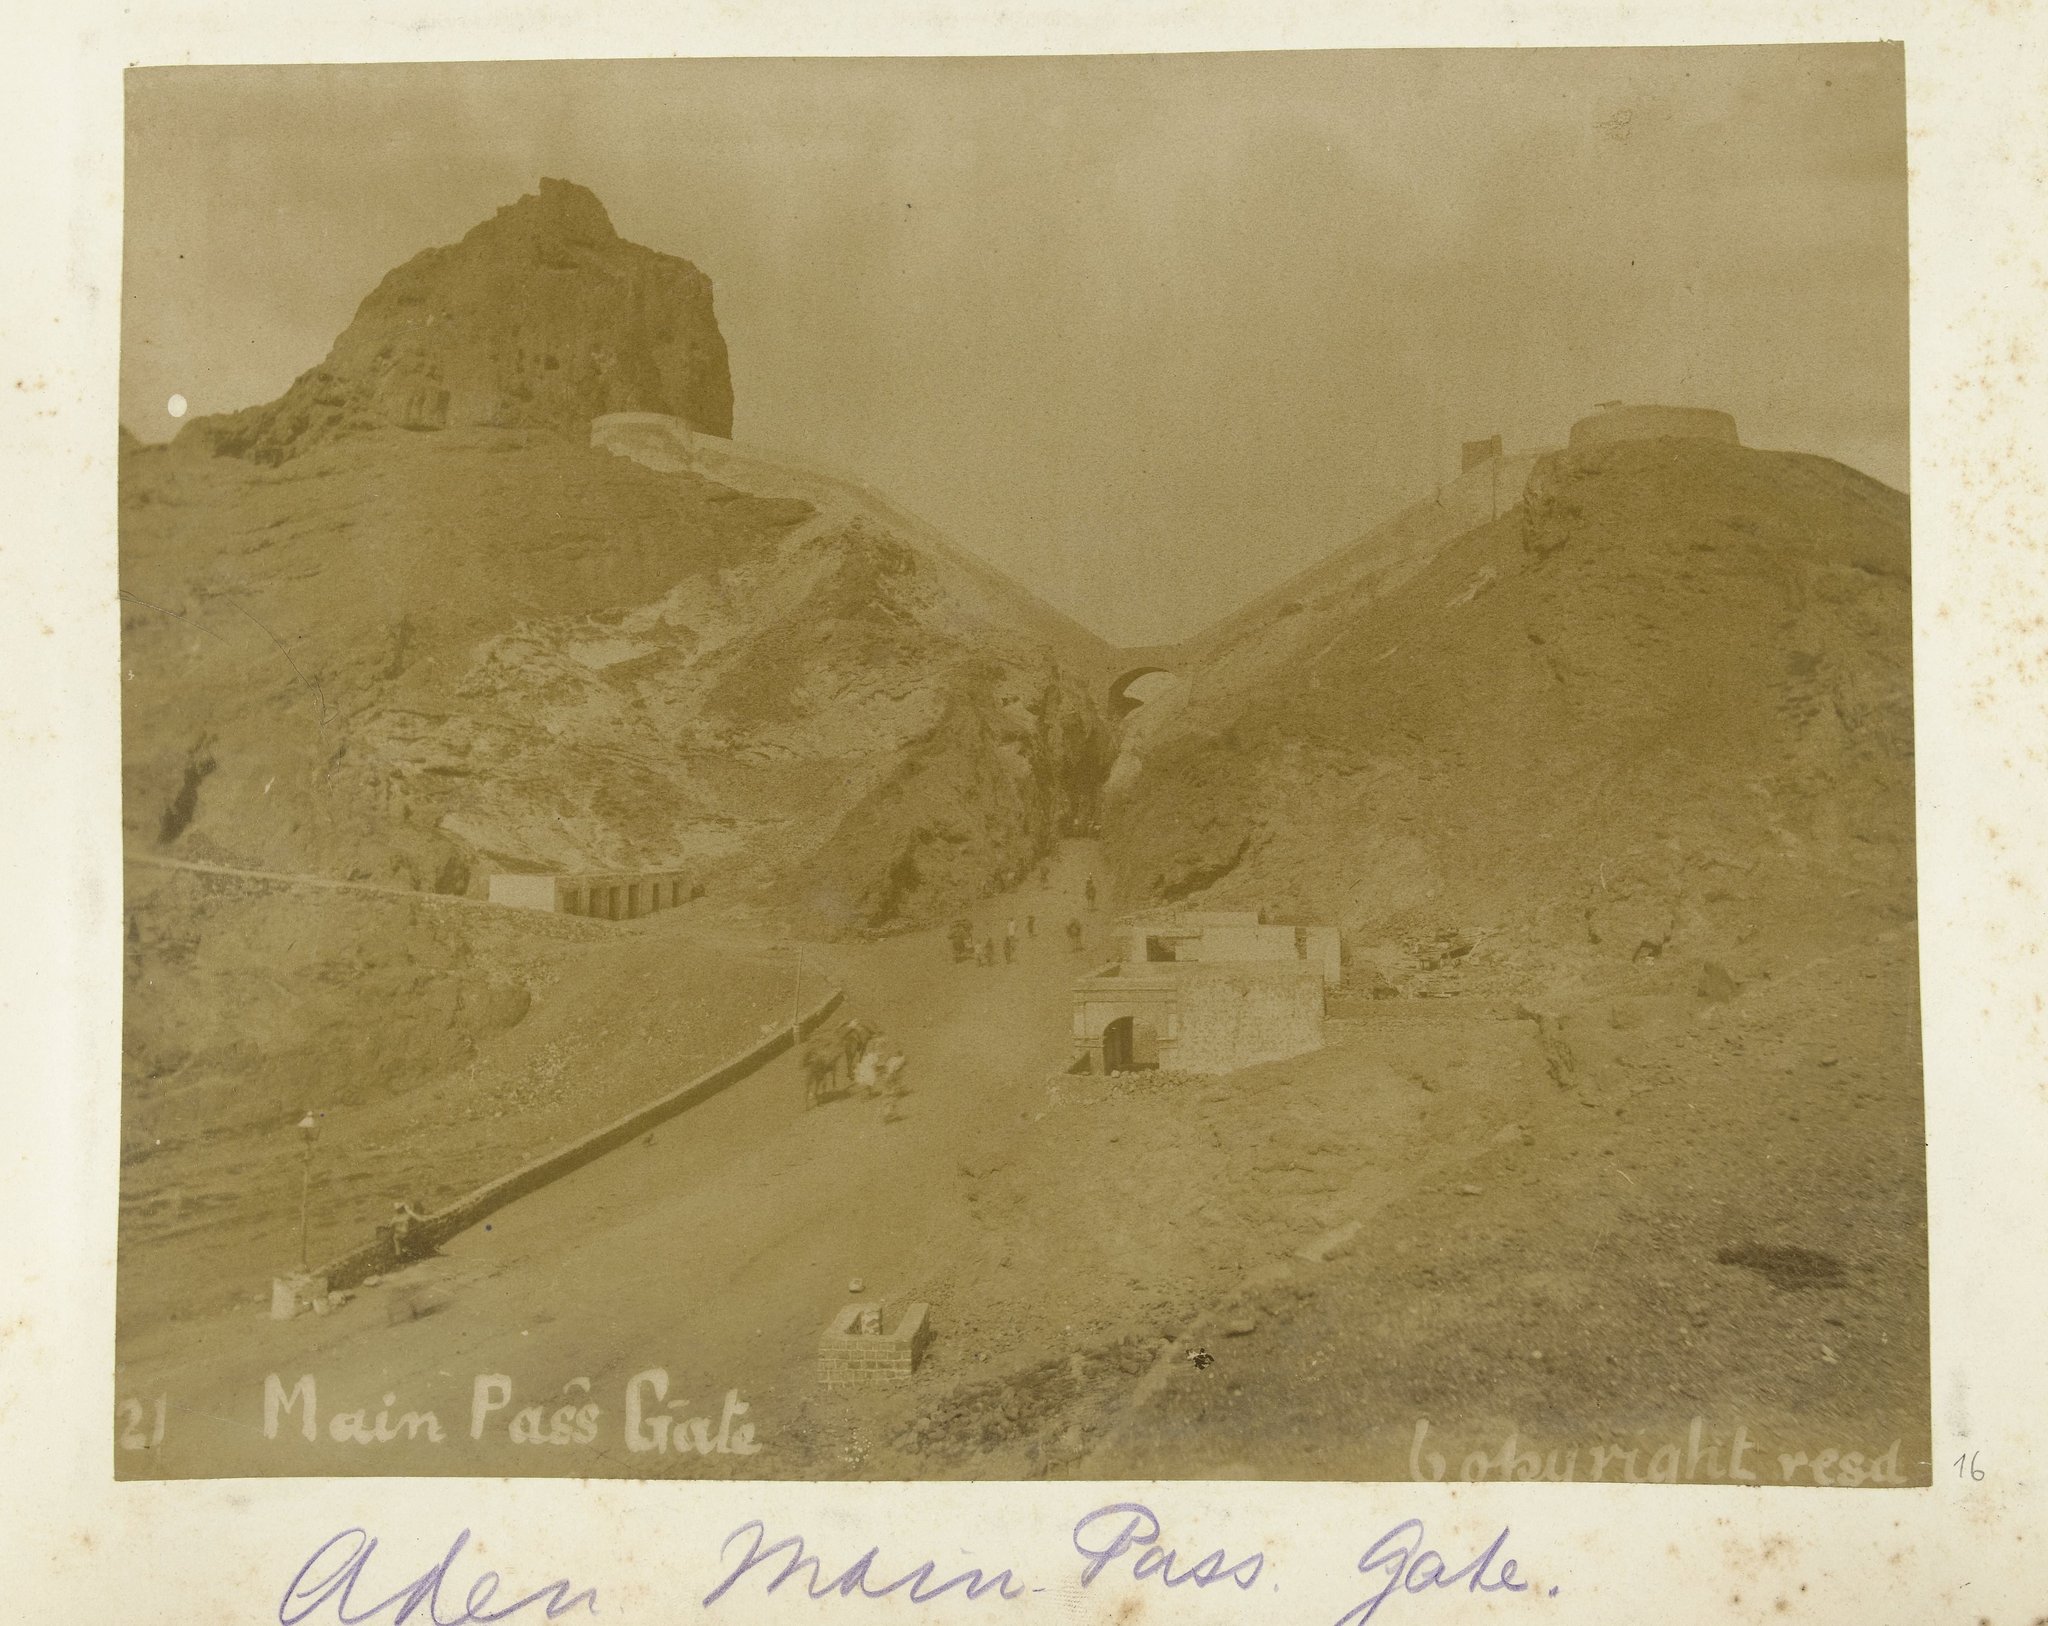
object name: photograph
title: Aden. Main pass gate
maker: Anonymous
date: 1890-1910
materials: cardboard, paper, photographic support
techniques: gelatin silver print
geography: netherlands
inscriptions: caption: ‘Aden. Main pass gate’